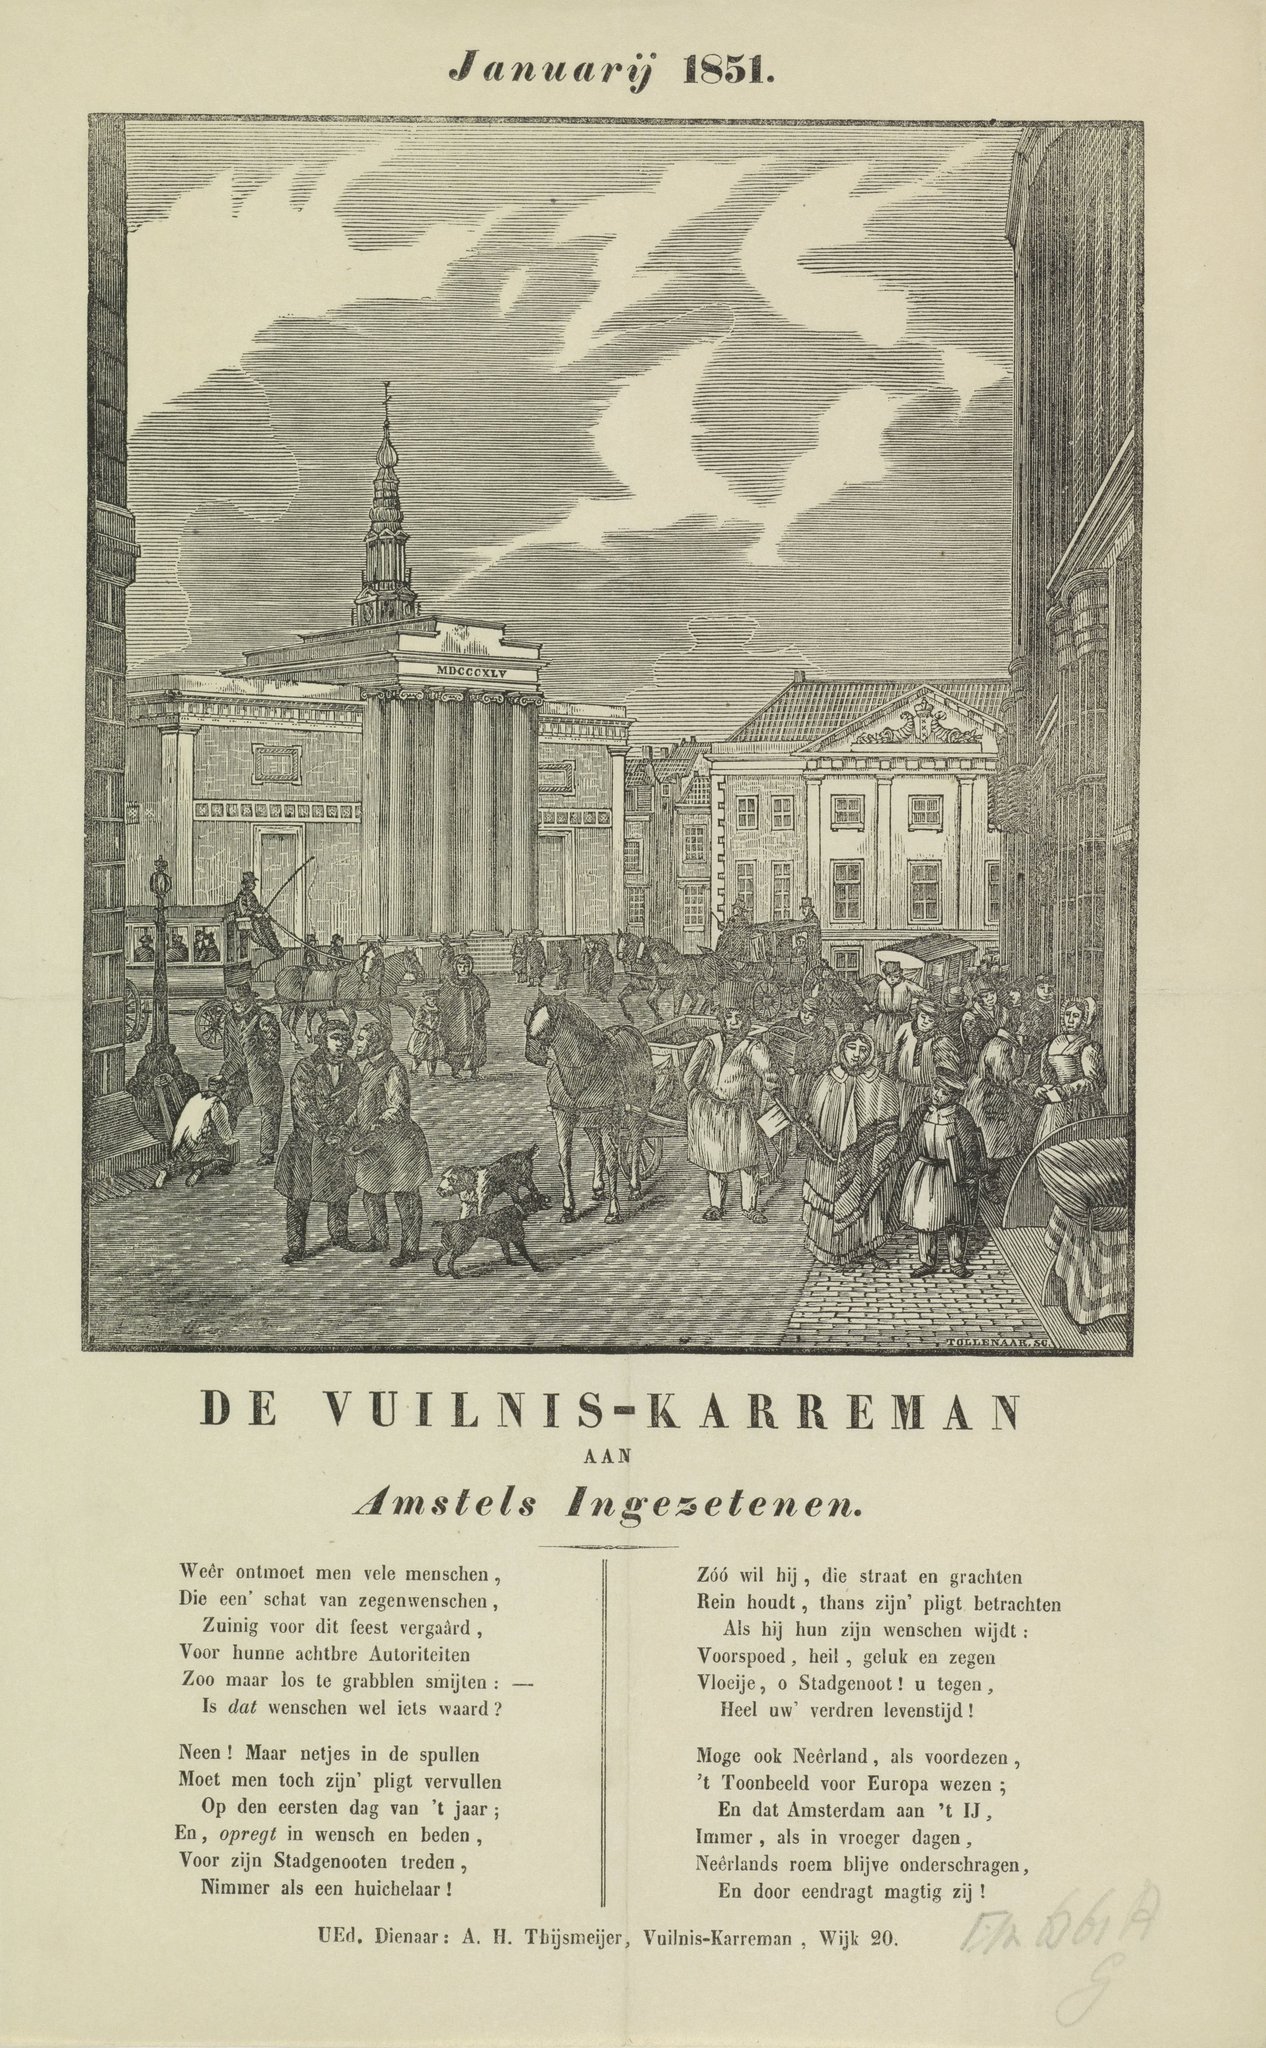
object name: new year card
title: Nieuwjaarswens van de vuilnismannen van Amsterdam voor het jaar 1851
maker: dirk wijbrand tollenaar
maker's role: print maker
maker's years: 1808-1858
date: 1850-1851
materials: paper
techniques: letterpress printing, engraving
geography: amsterdam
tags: street, garbage collection, amsterdam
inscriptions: collector's mark: Lugt 2228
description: Nieuwjaarswens van de Amsterdamse vuilnismannen voor het jaar 1851. Gezicht op de Dam met de Beurs van Zocher en het Commandantshuis te Amsterdam. Tussen het publiek de vuilnismannen met hun kar. Met gedicht in twee kolommen. Van de vuilniskarman in de wijk no. 20: A.H. Thijsmeijer.